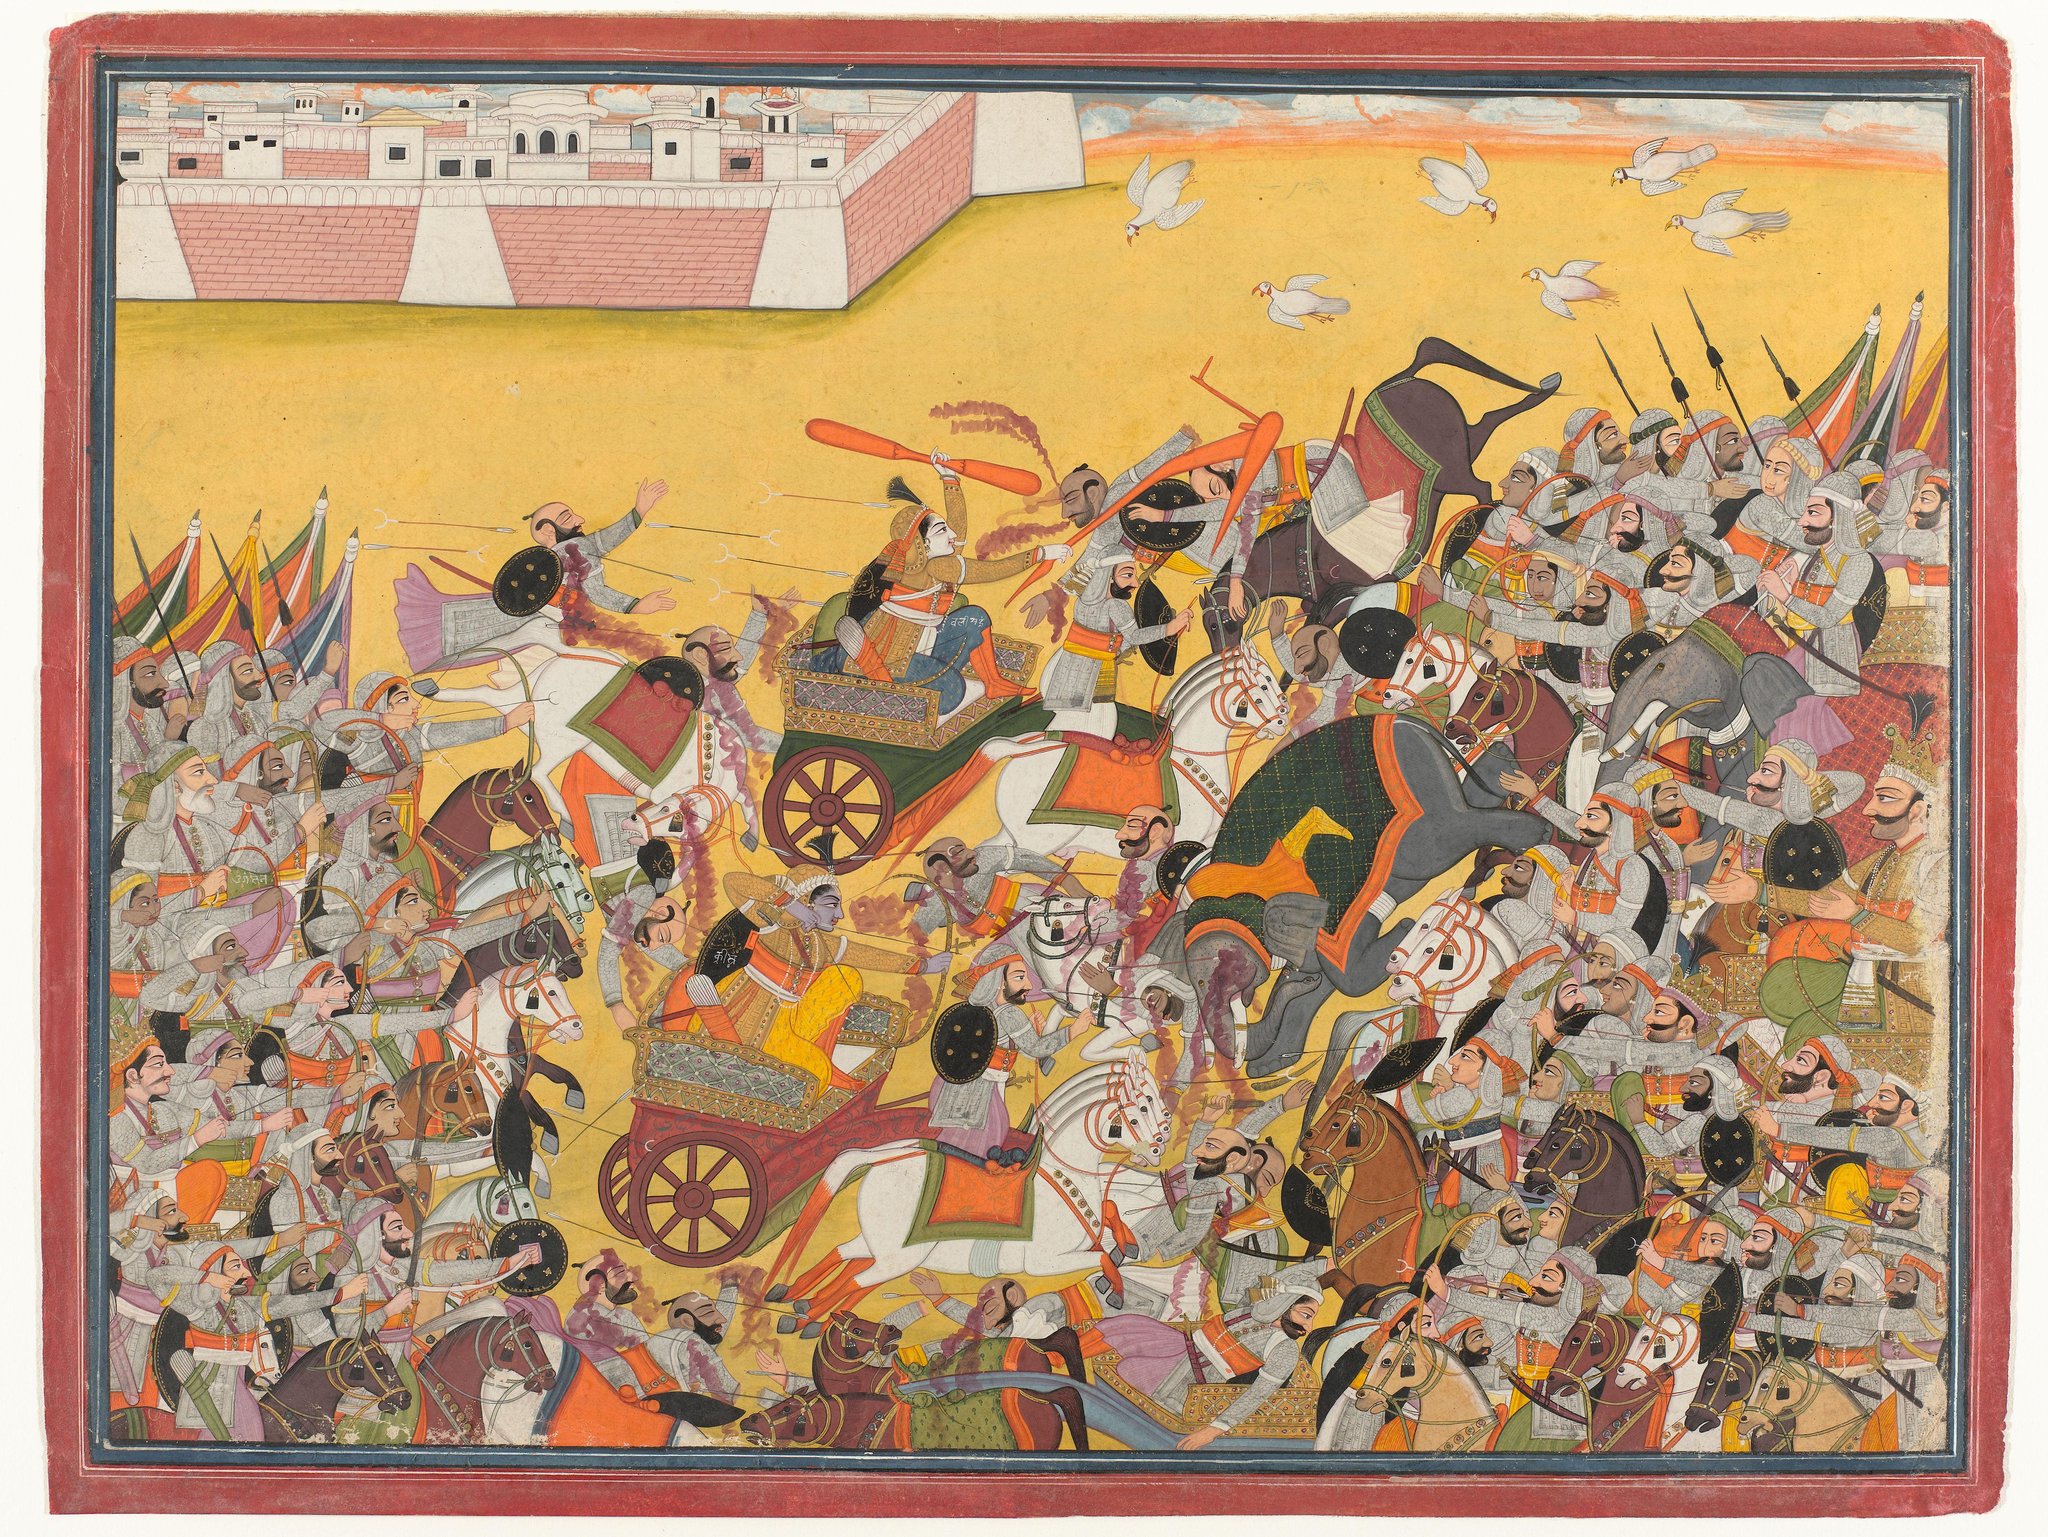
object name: indian miniature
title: De toorn van Jarasandha bij Mathura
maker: Anonymous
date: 1850-1899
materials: paint, gouache, paper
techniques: brush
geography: kangra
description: De toorn van Jarasandha bij Mathura, uit de Mahabharata (Sanskriet-epos).